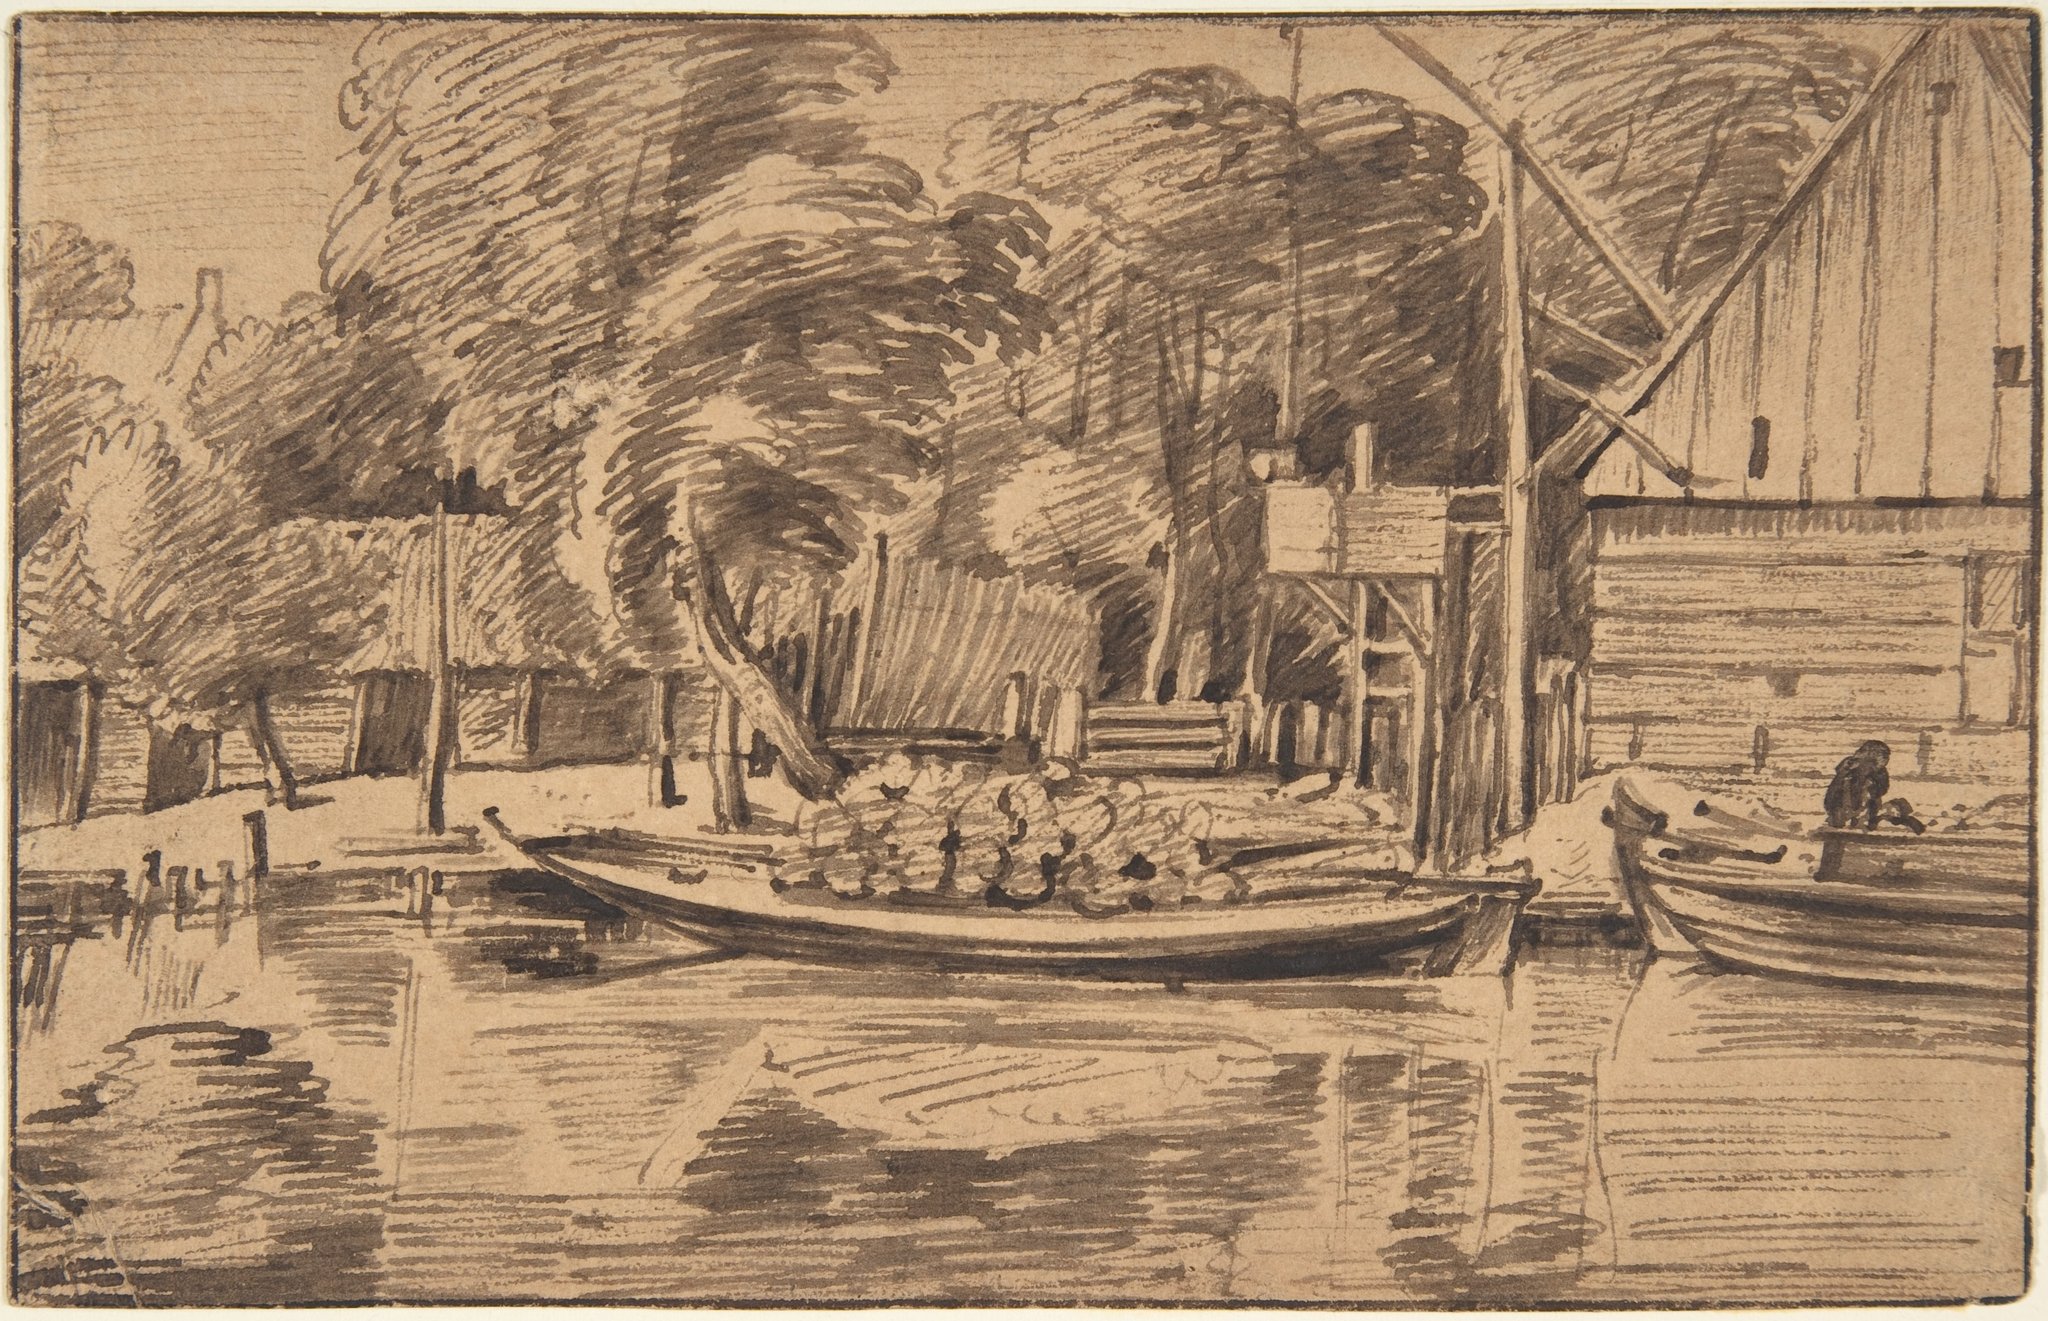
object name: drawing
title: Landscape with a Canal in the Foreground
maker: johannes leupenius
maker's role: artist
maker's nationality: dutch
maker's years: 1643-1693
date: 1601-1700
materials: ink, paper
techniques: pen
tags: houses,canals,landscapes,trees,boats